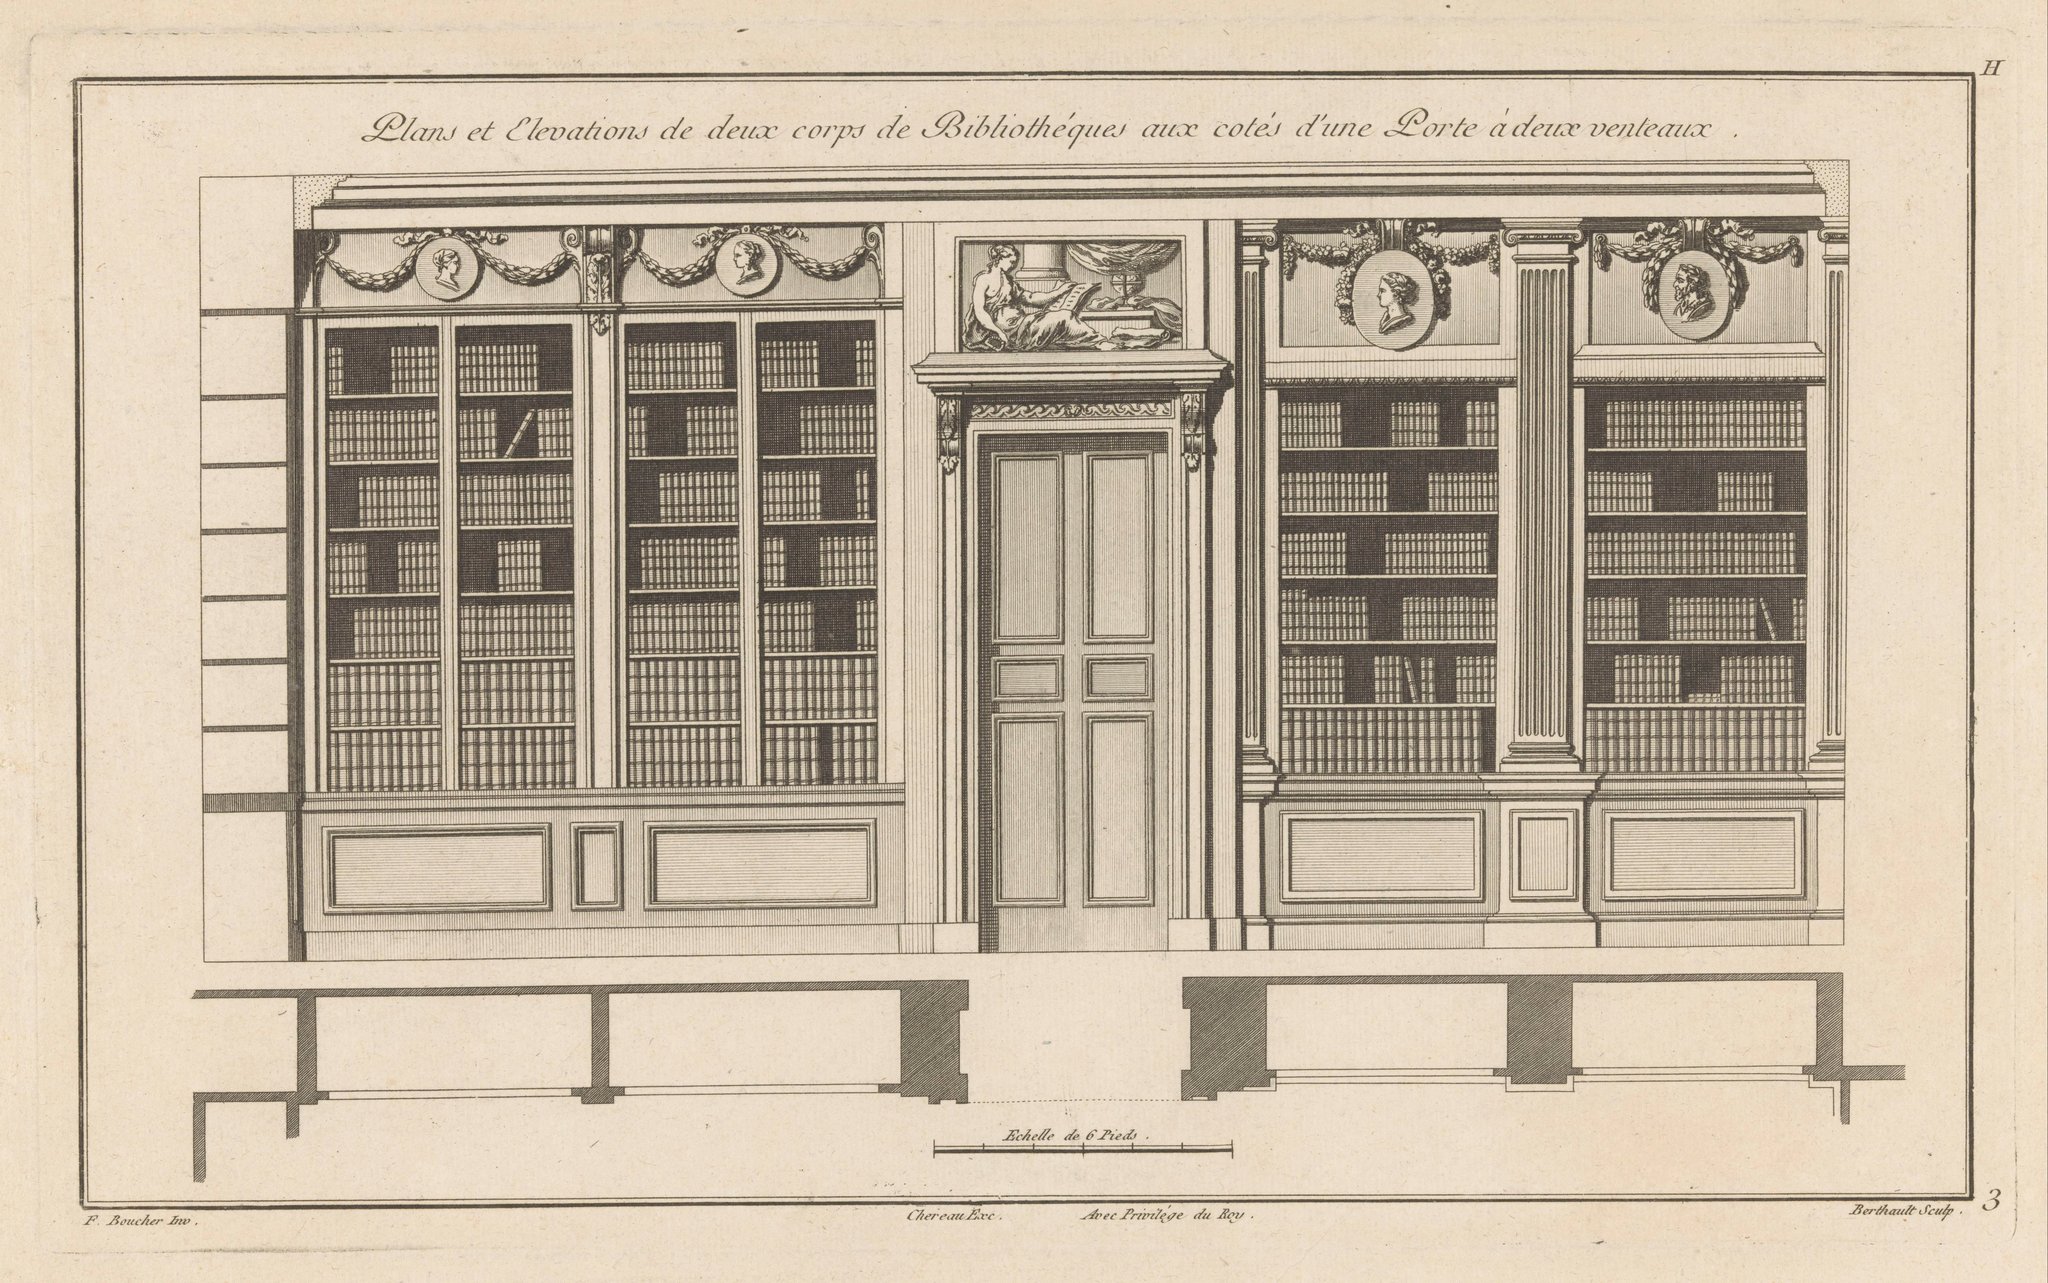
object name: ornament print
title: Plans et Elevations de deux corps de Bibliothéques aux cotés d'une Porte à deux venteaux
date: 1752-1794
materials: paper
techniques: engraving, etching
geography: paris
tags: bookshelves, reading, ornament ~ medallion, door, ornament ~ festoon, garland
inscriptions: collector's mark: Lugt 2760, collector's mark: Lugt 2228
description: Ontwerp en plattegrond van twee boekenkasten aan weerszijden van een deur met dessus-de-porte met een lezende vrouw. Boven de kasten panelen met guirlandes en portretten en profil in medaillons.